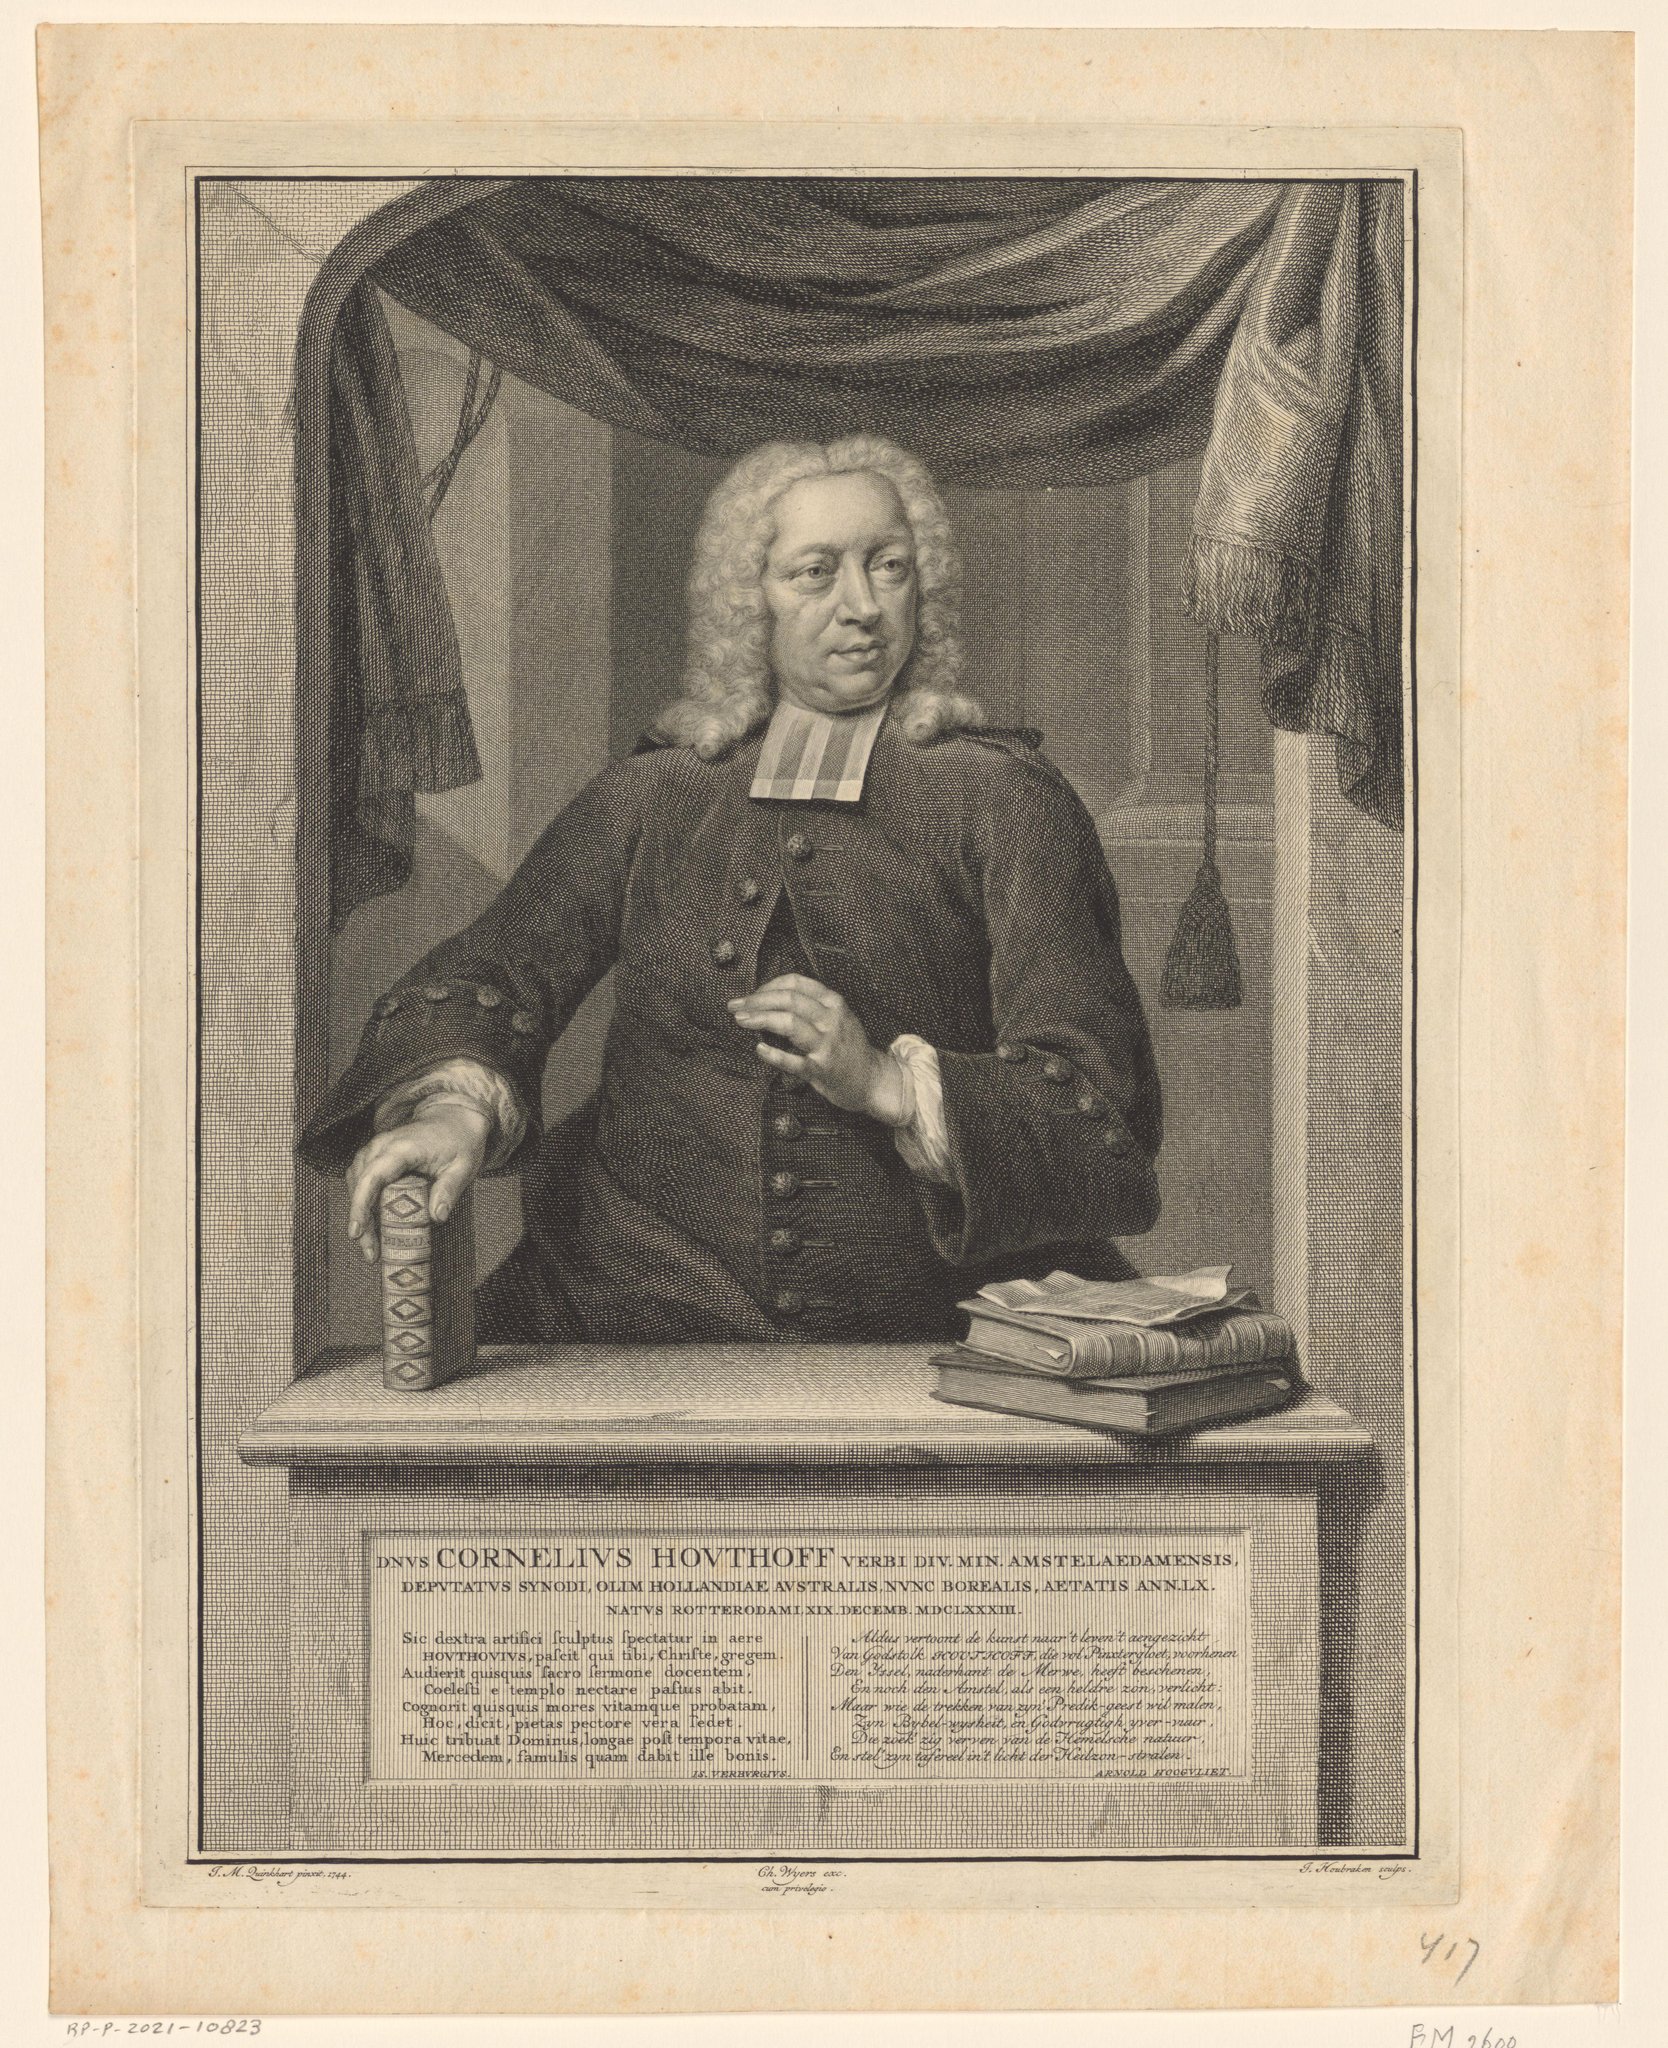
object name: print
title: Portret van Cornelis Houthoff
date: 1744-1745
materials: paper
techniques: engraving, etching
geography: amsterdam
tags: rotterdam, amsterdam, historical persons, the bible as a book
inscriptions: collector's mark: Lugt 2228